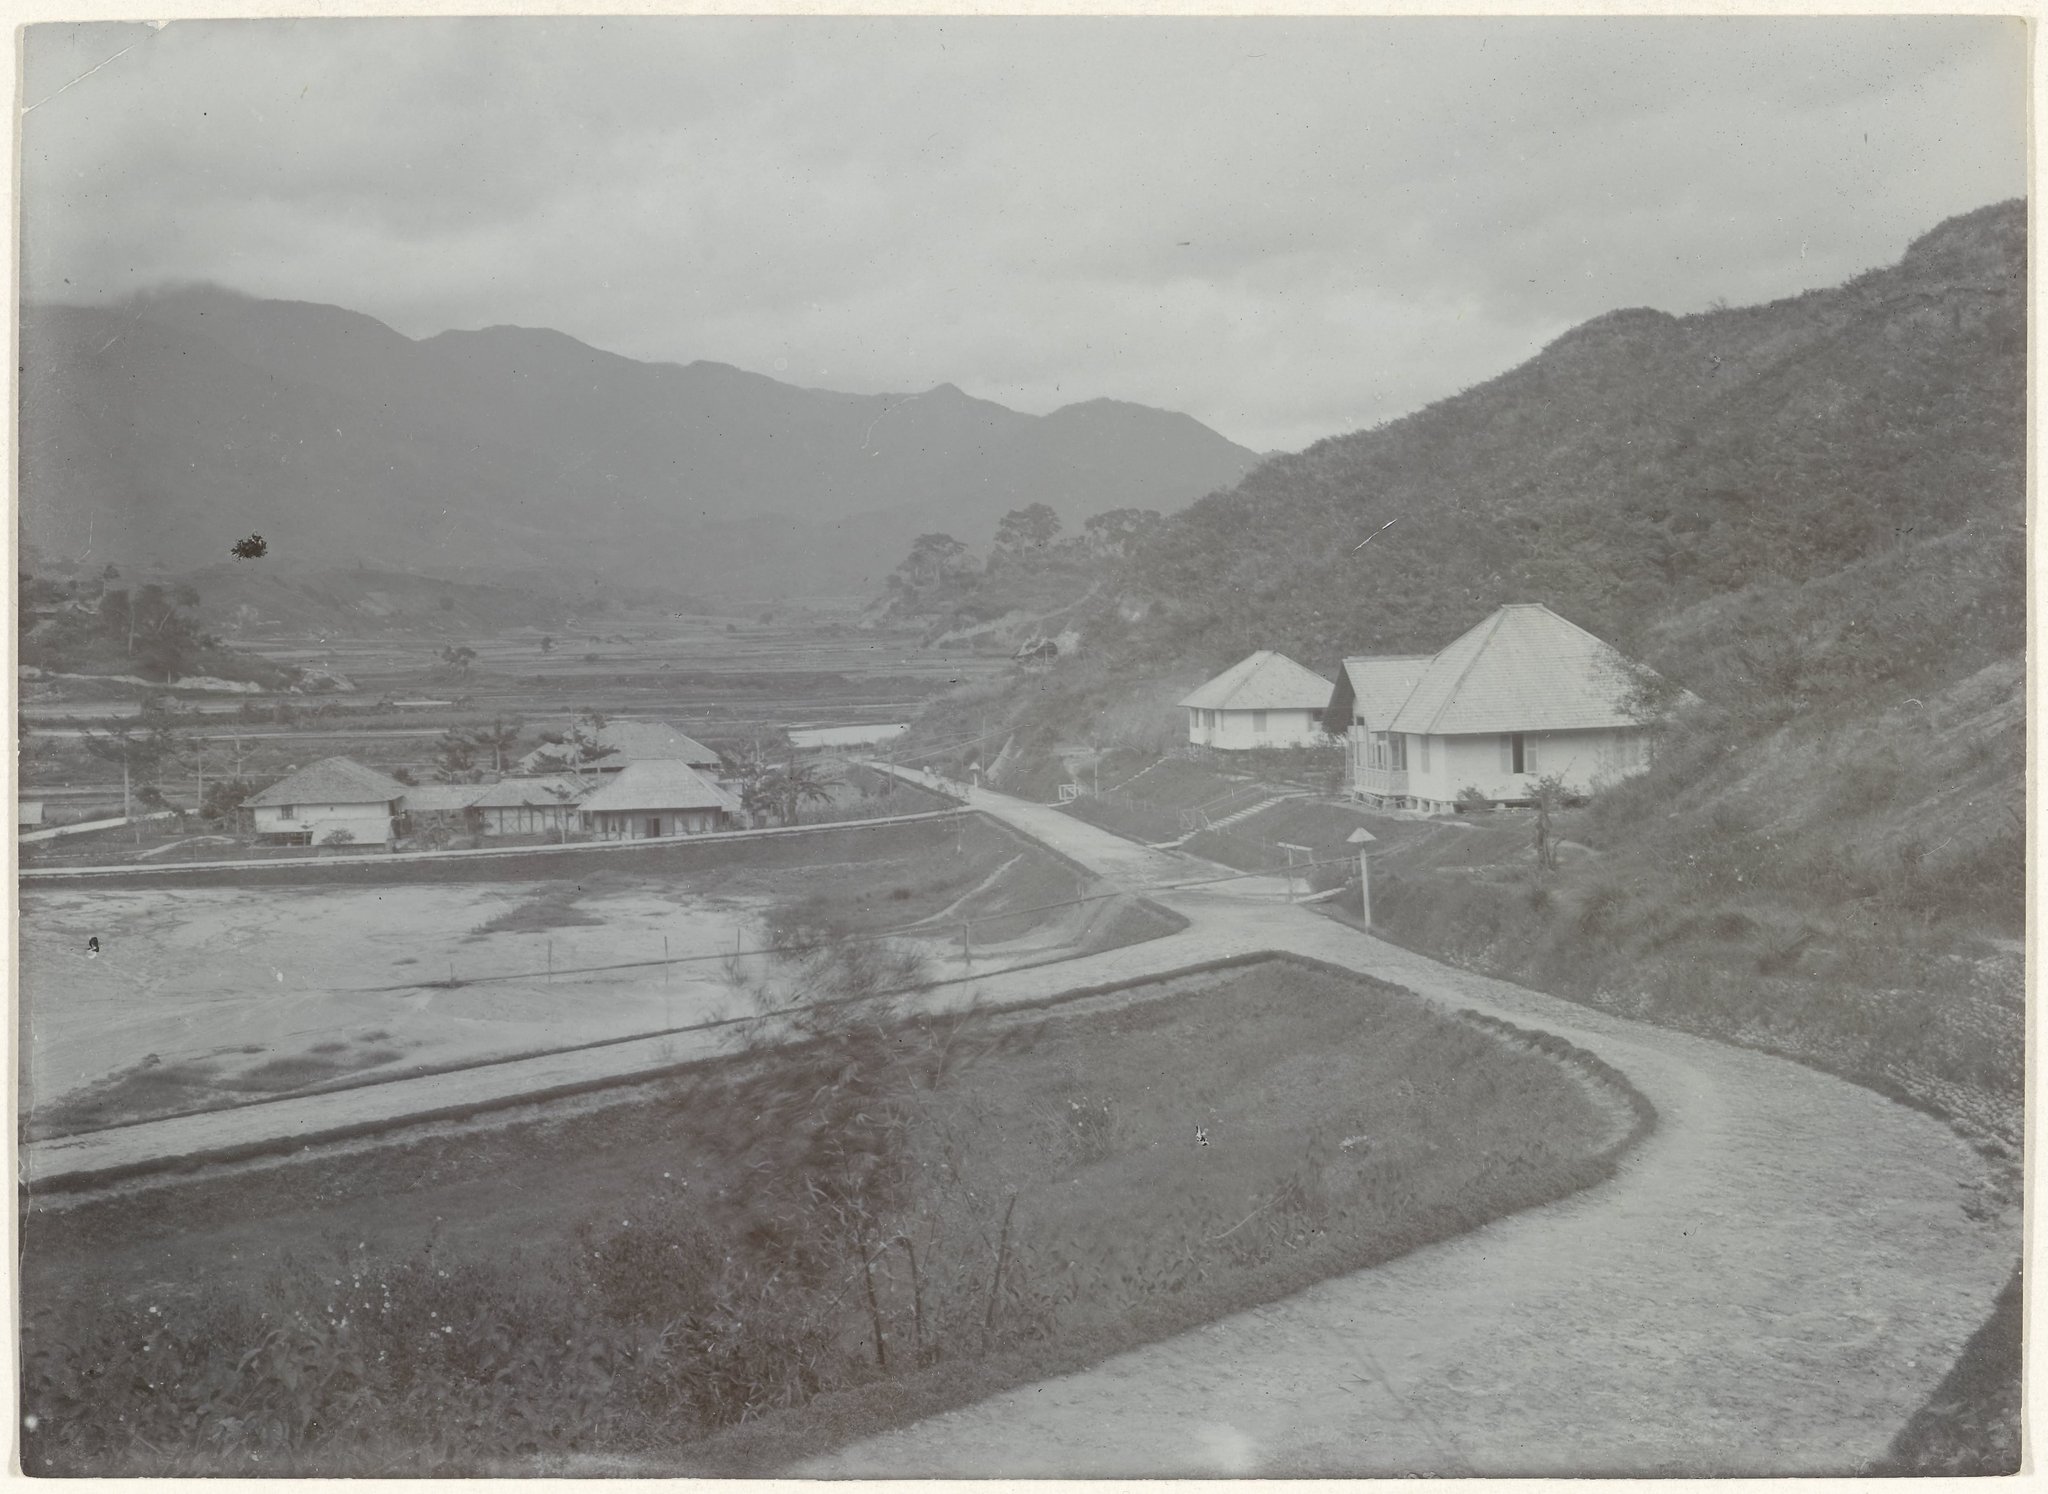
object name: photograph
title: Senawang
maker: Anonymous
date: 1920-1940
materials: photographic support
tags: borneo